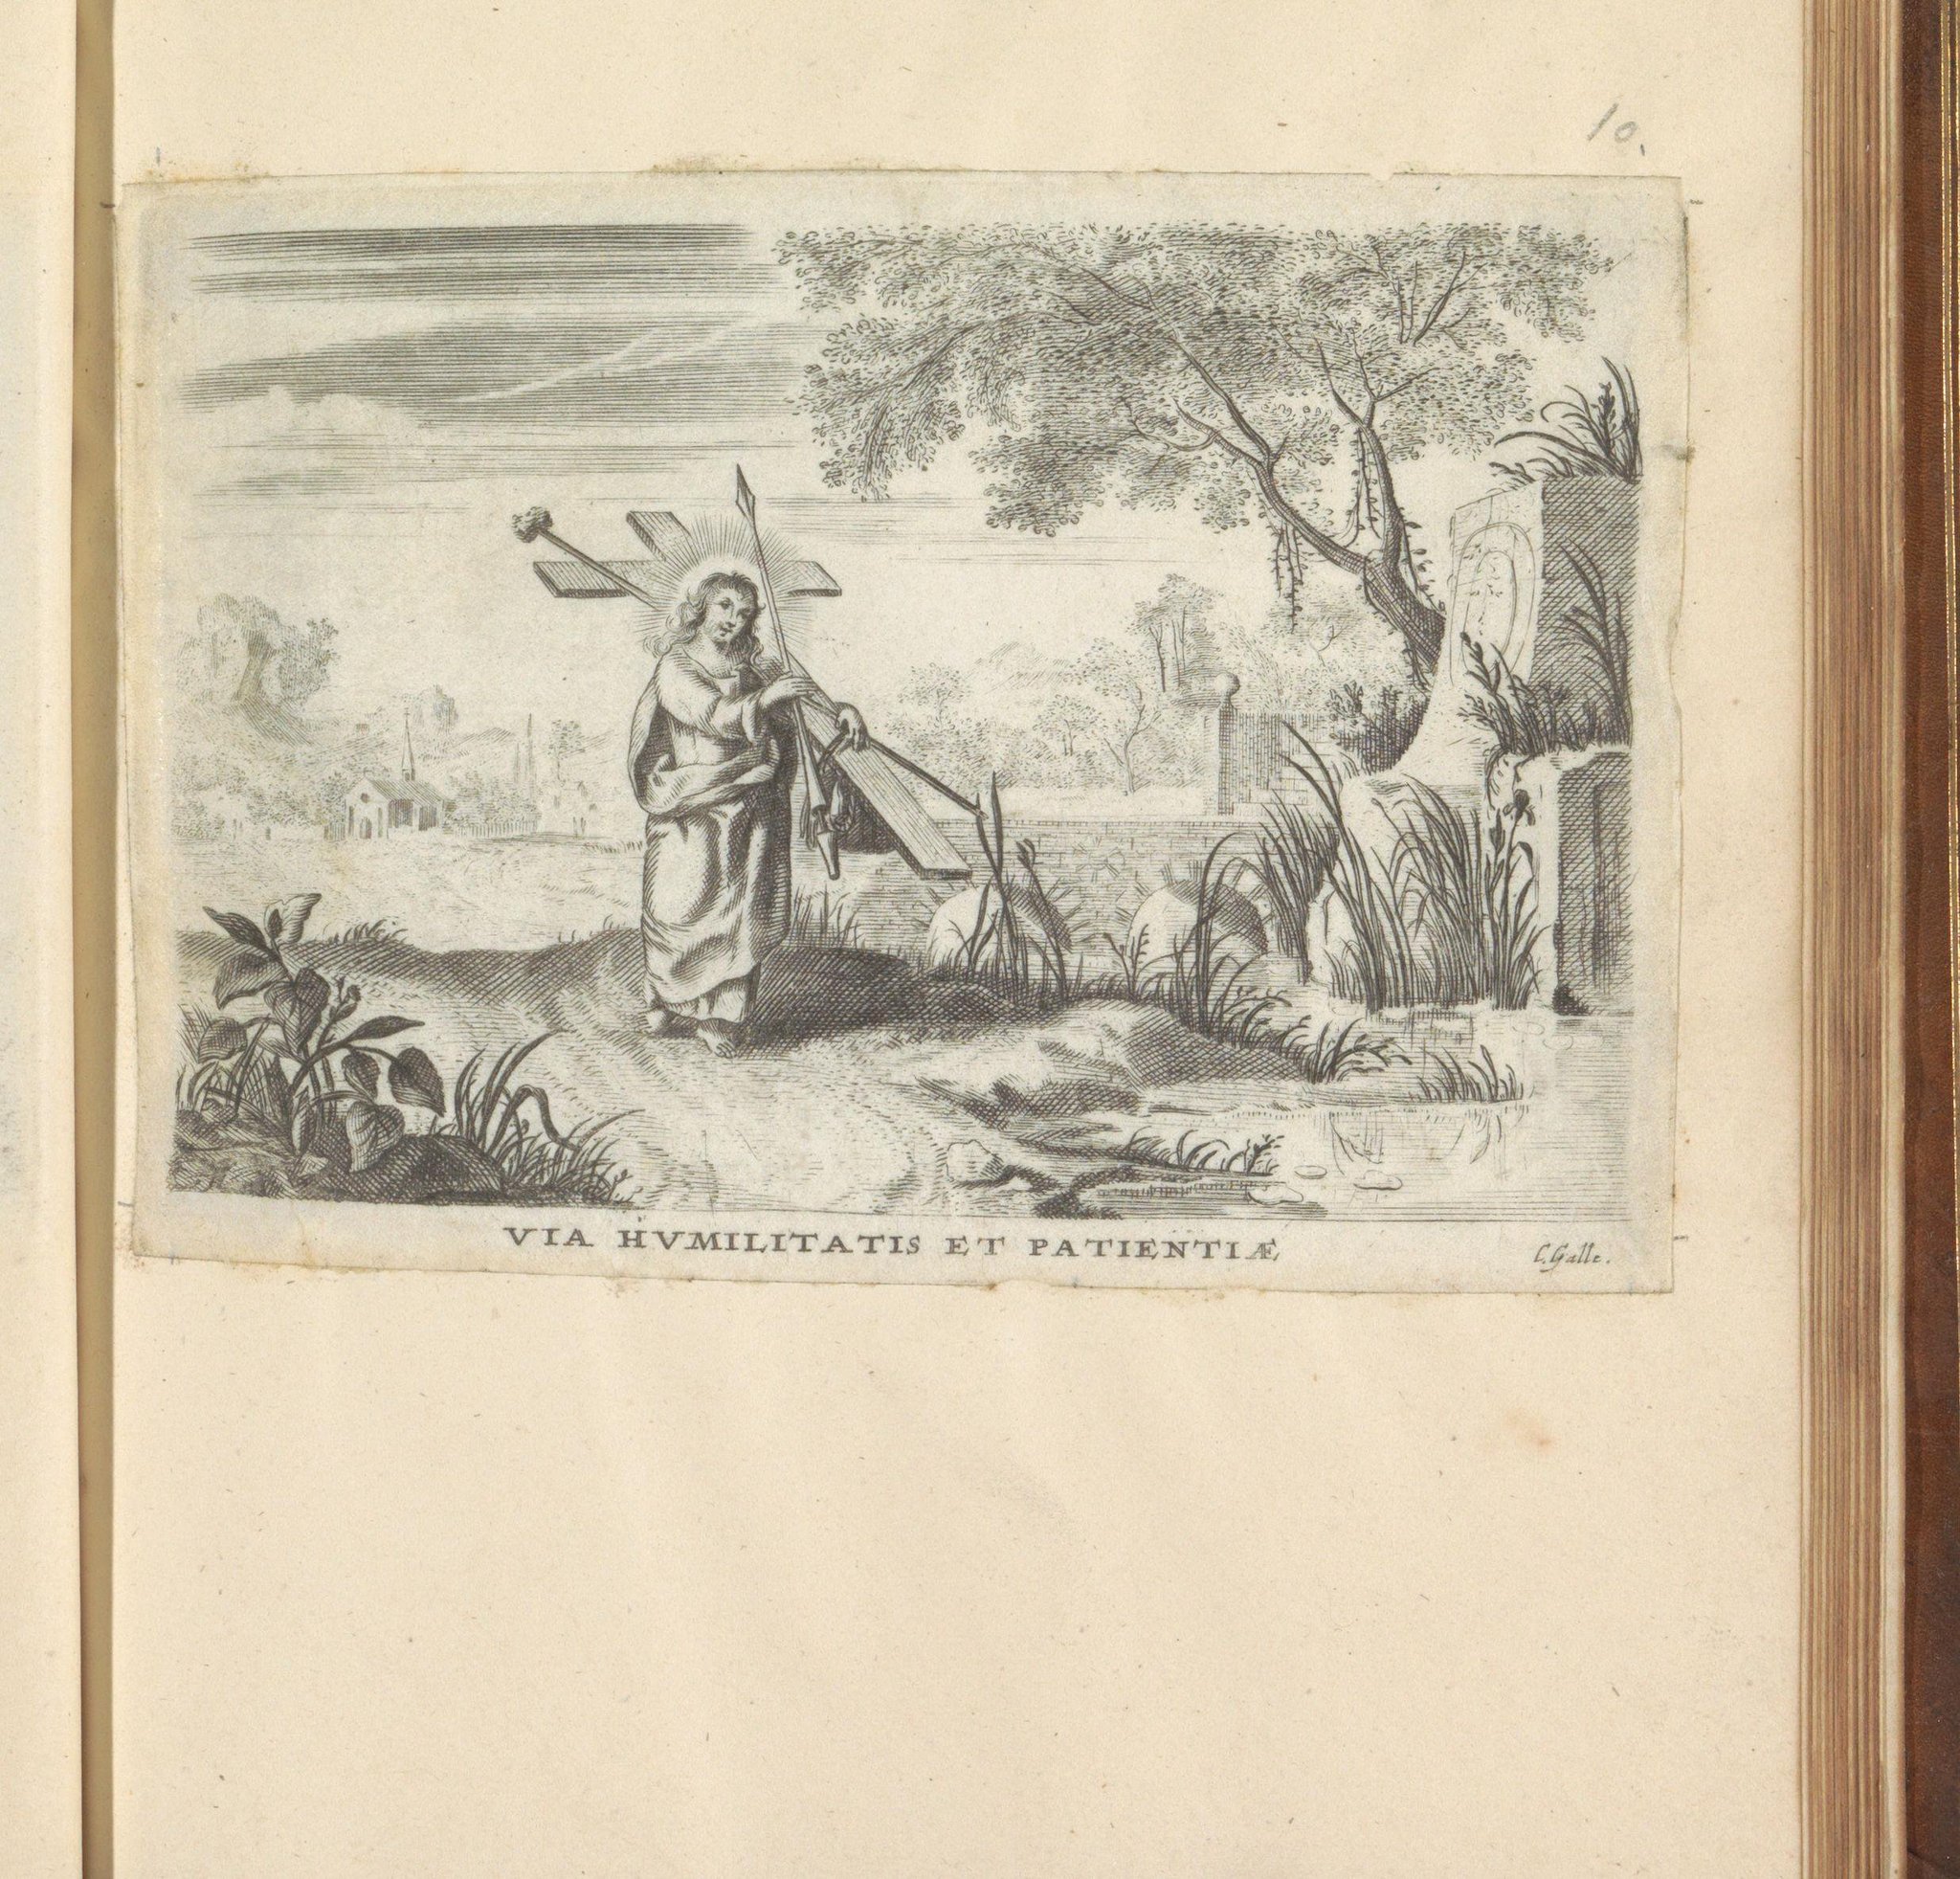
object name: print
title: Landschap met Christus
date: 1640-1678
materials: paper, parchment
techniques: engraving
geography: antwerp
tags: christ-child carrying the instruments of the passion, christ-child carrying the cross, carrying of the cross: christ bearing the cross, alone or with the help of others (e.g. simon the cyrenian)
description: Landschap met Christus gaande over een weg, hij draagt de passiewerktuigen. Eén prent uit prentalbum met negentien devotionele prenten op perkament.